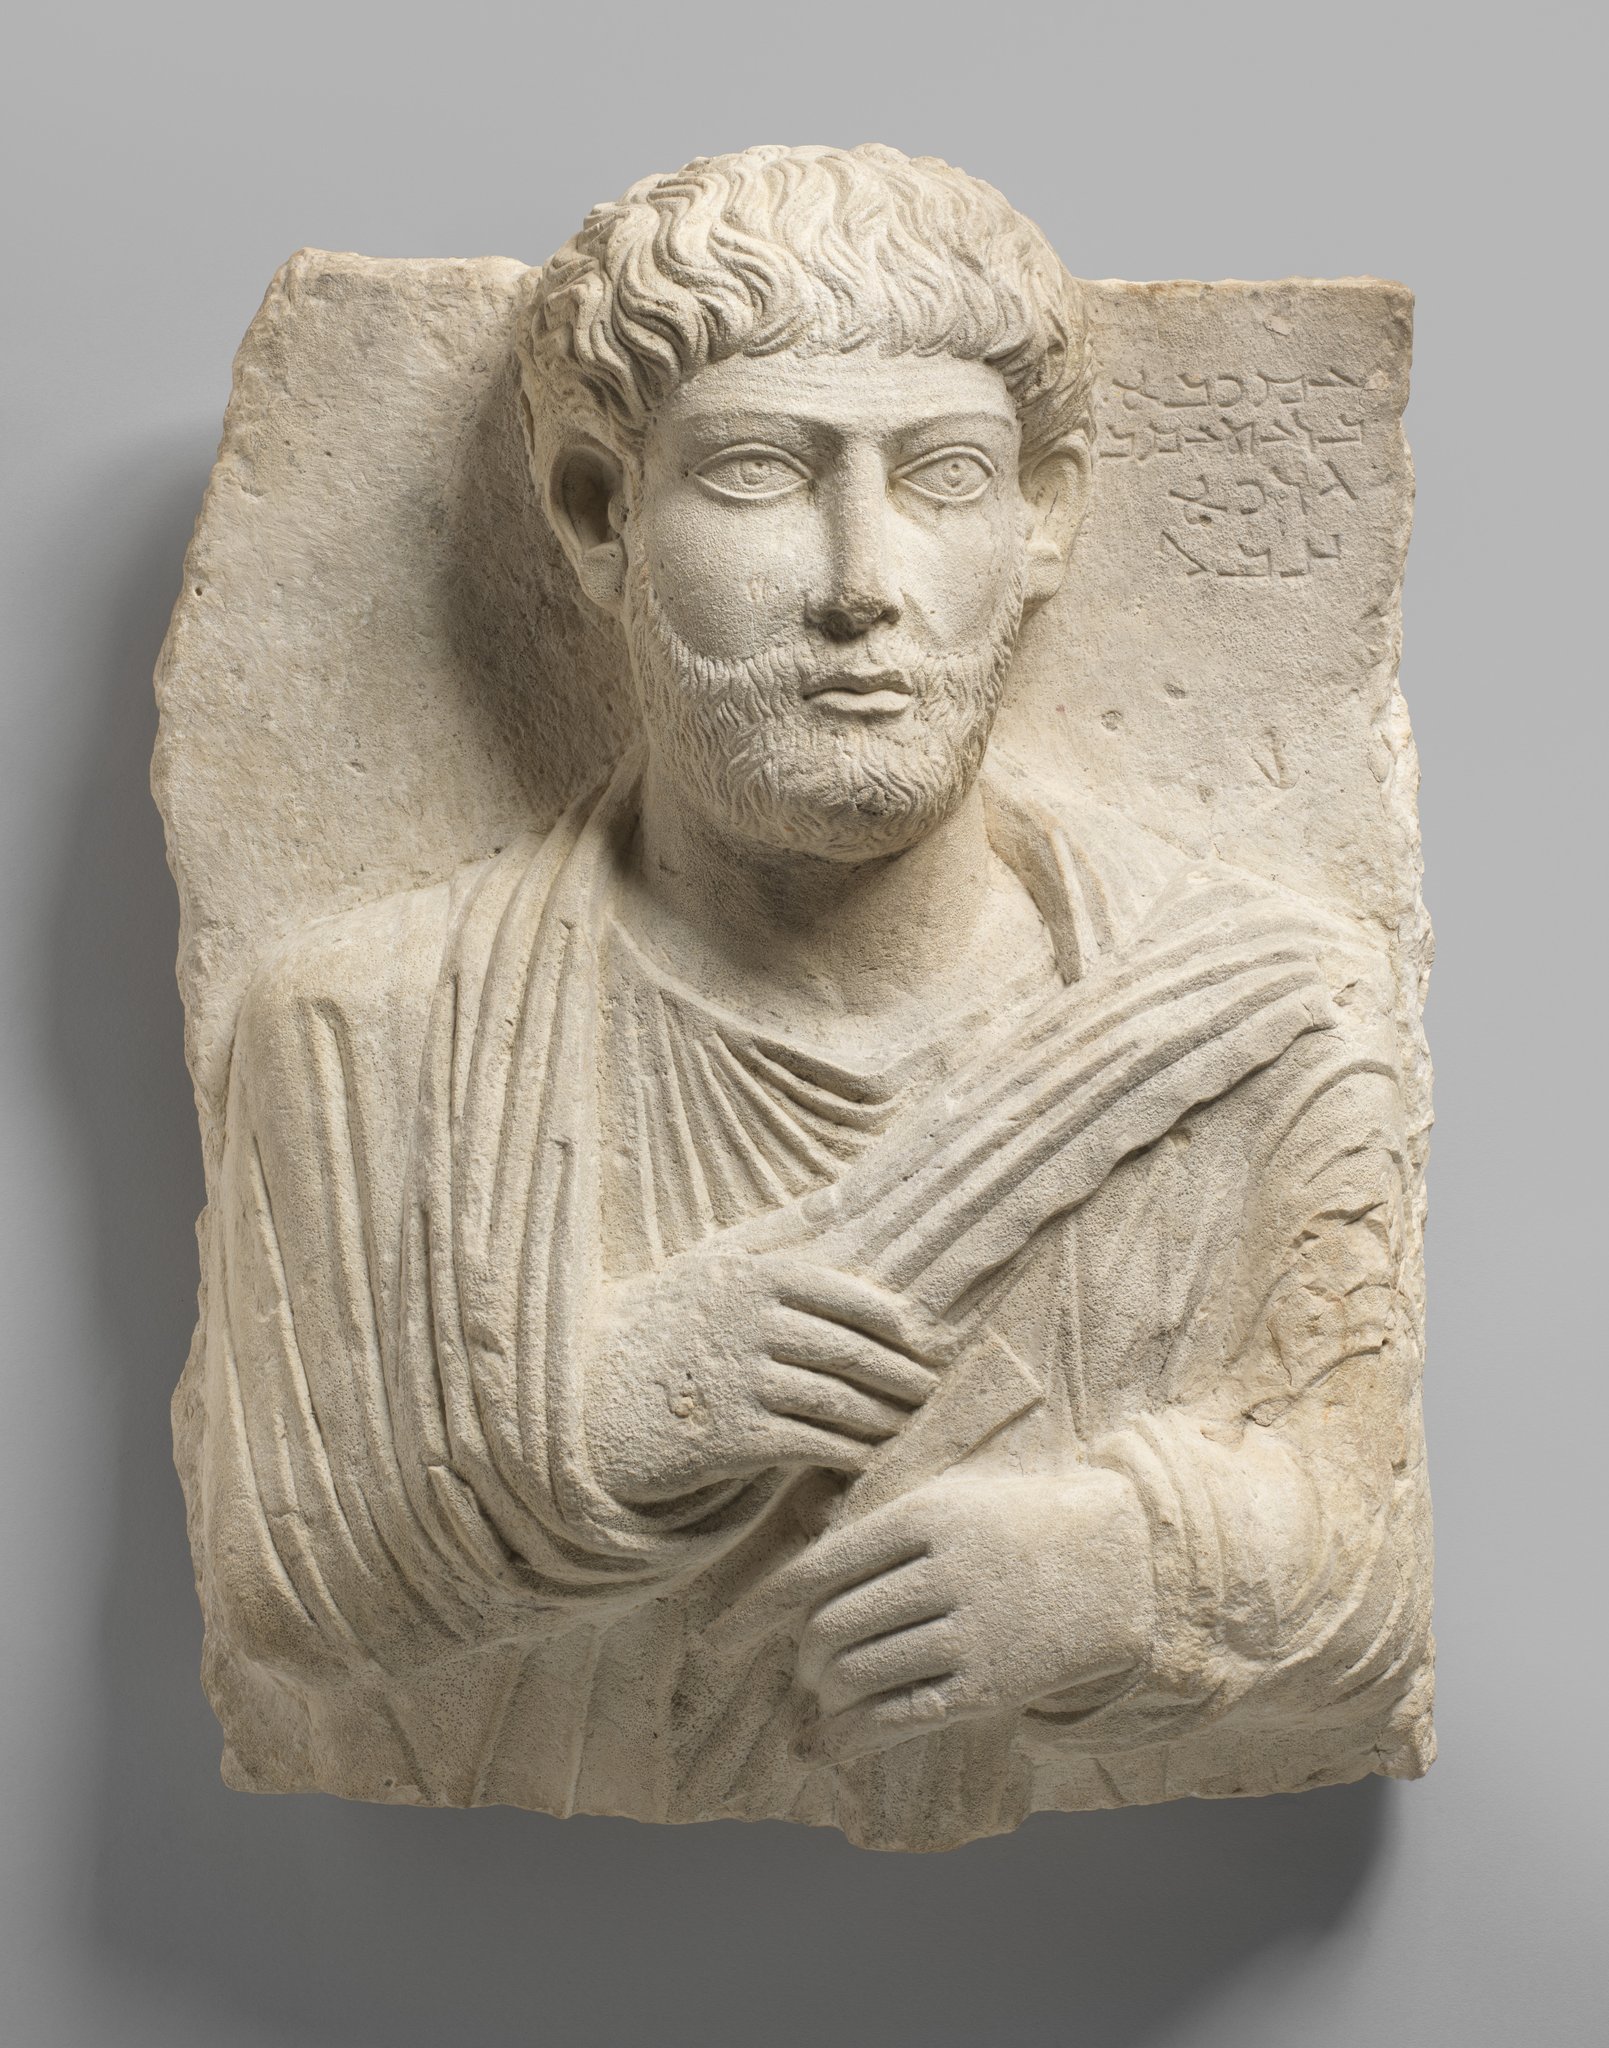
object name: funerary relief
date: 150-200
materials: stone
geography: syria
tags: men,portraits